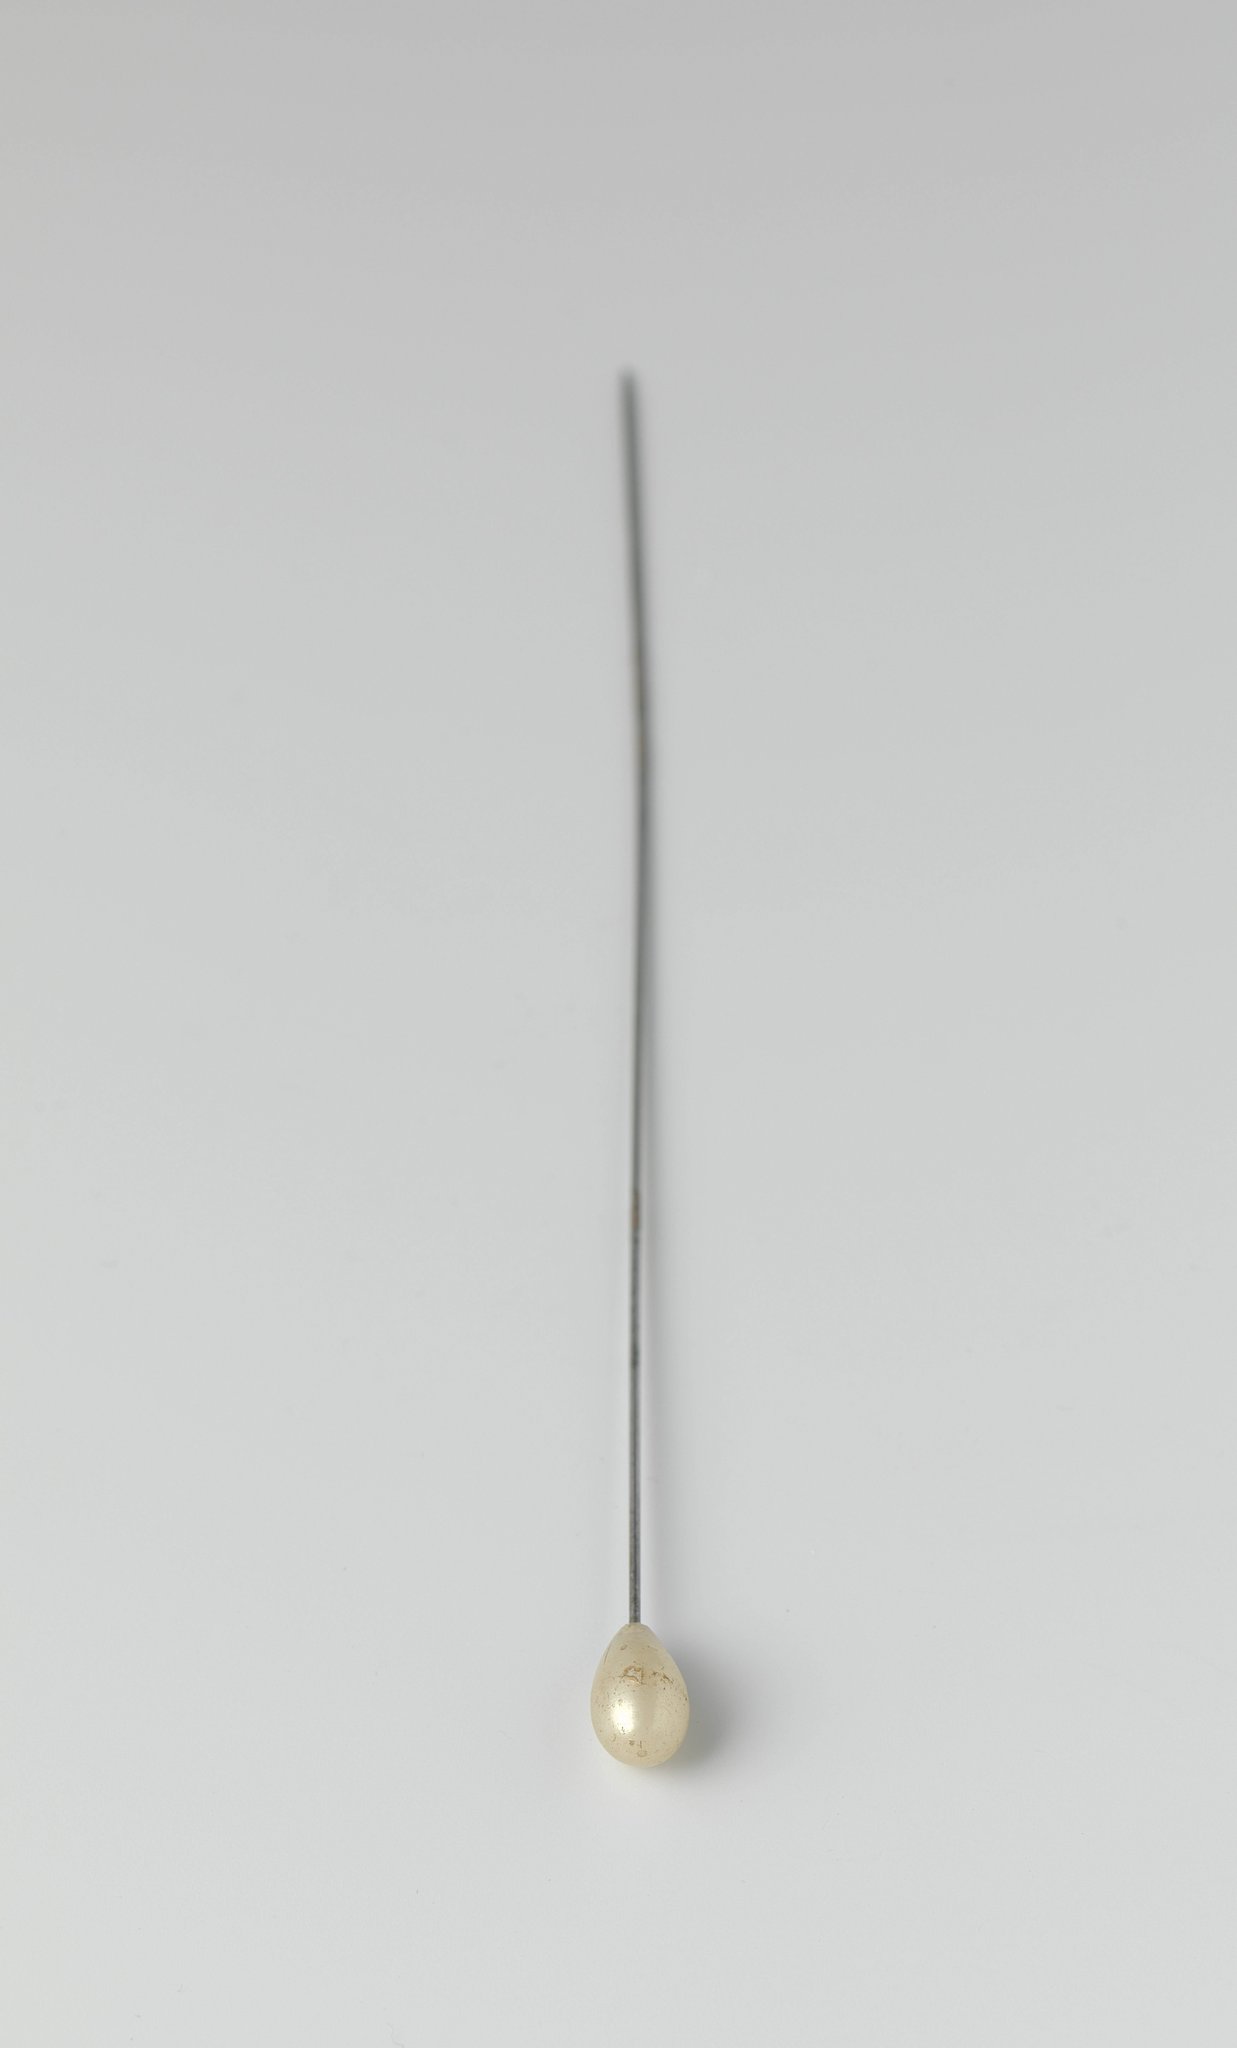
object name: hatpin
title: Hoedenspeld met bolronde witte knop van bakeliet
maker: Anonymous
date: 1910-1930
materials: bakelite, metal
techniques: forging, pressing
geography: netherlands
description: Hoedenspeld met bolronde witte knop van bakeliet (?).